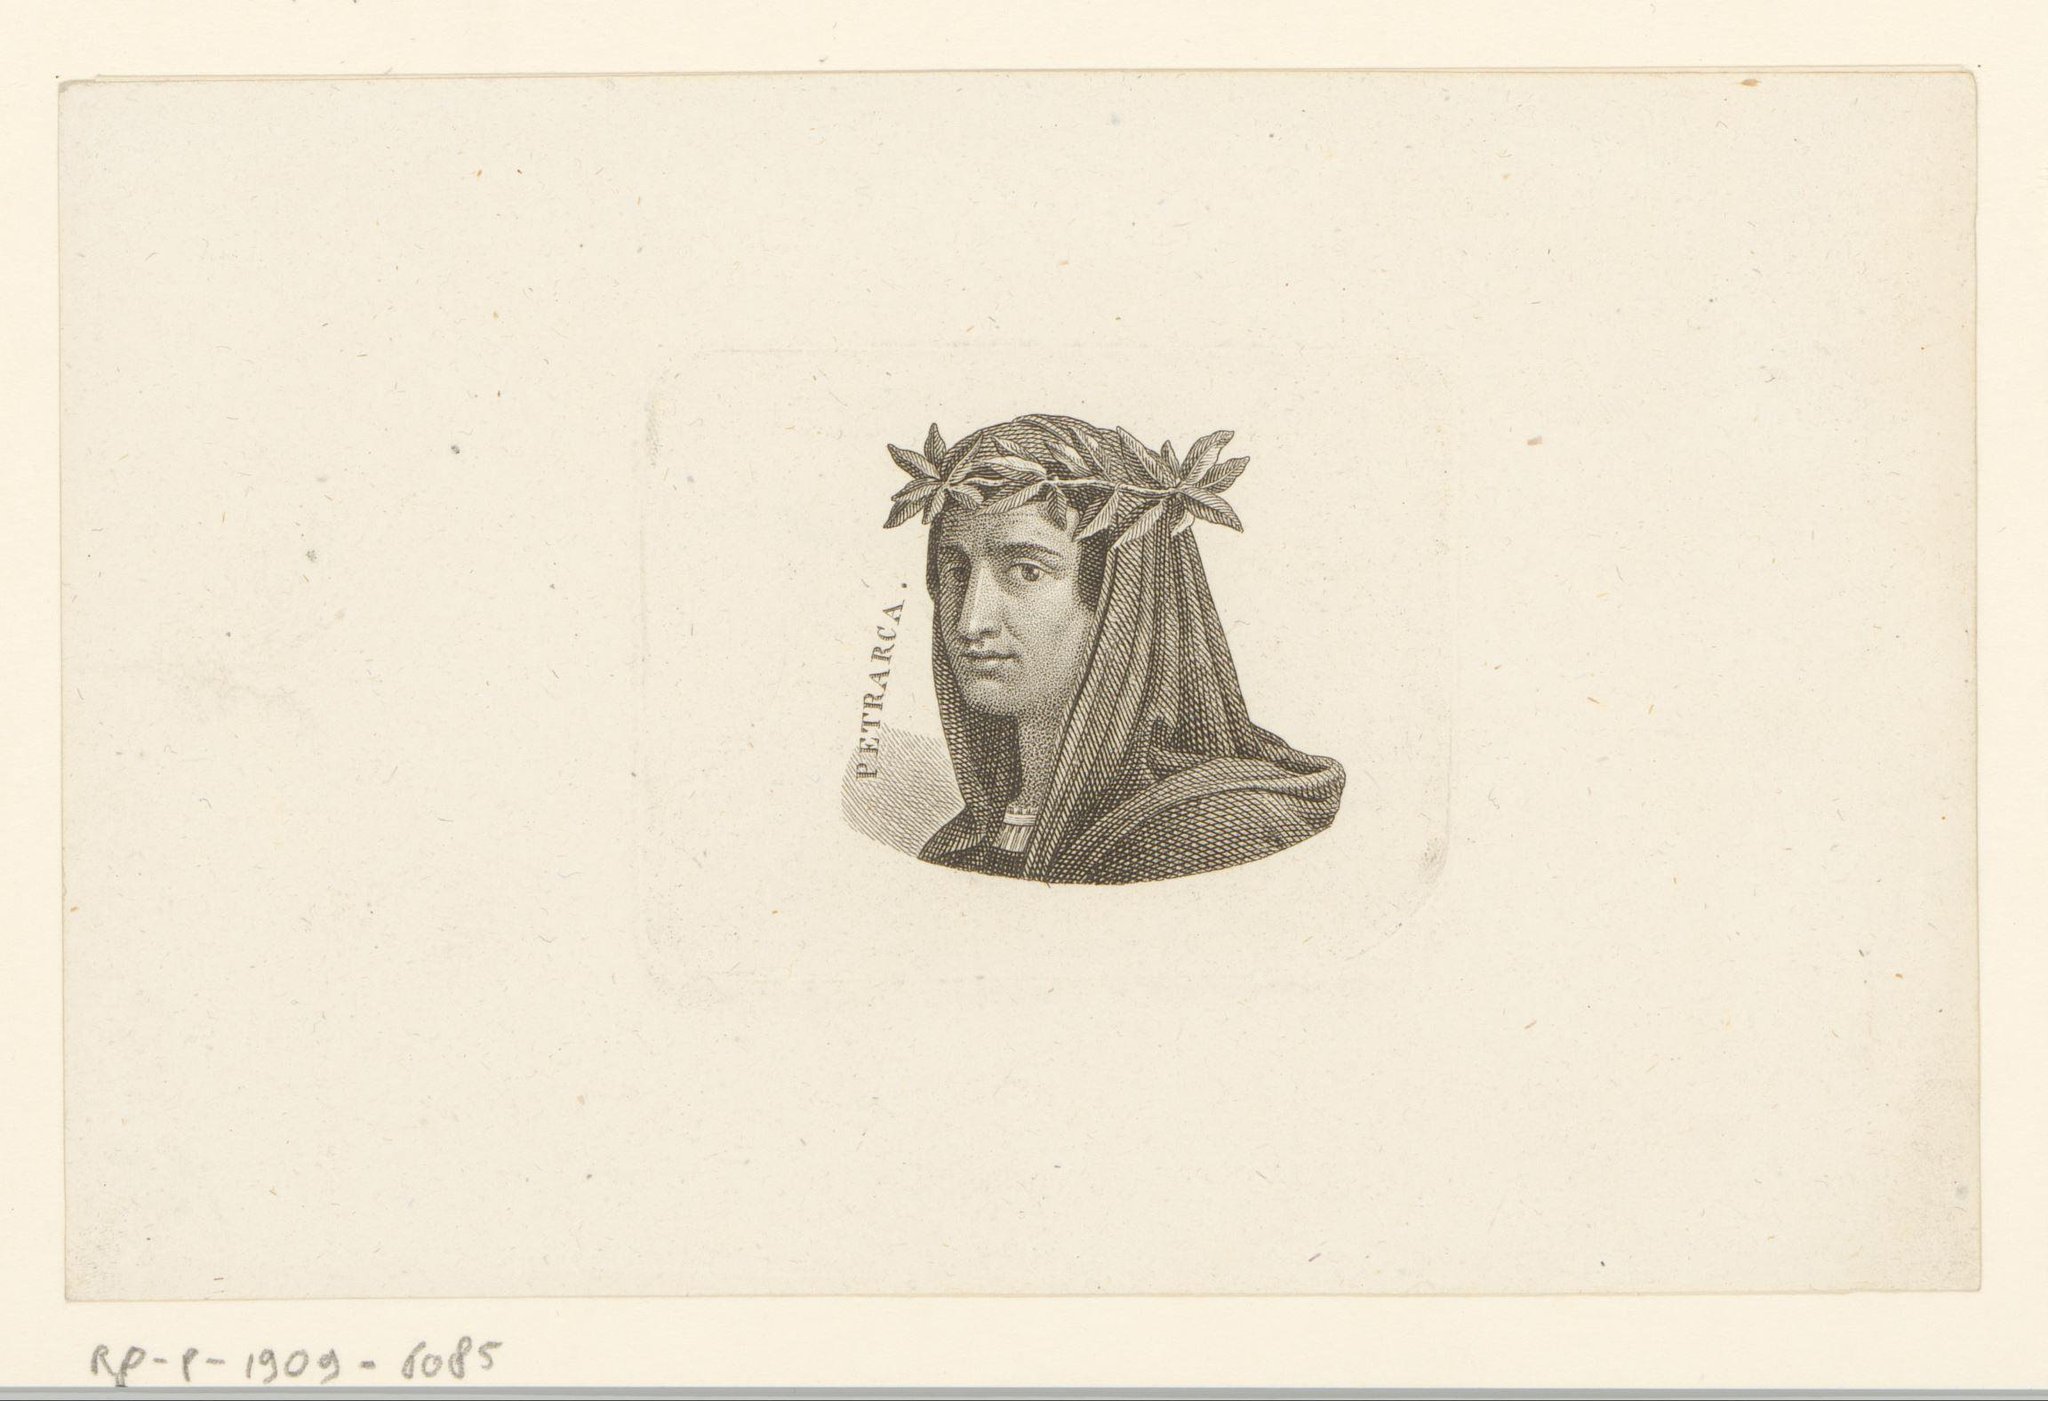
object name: print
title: Portret van Francesco Petrarca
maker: ernst ludwig riepenhausen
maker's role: print maker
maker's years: 1765-1840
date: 1775-1840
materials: paper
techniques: engraving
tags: francesco petrarca, honouring the artist with laurel wreath, historical persons, portrait of a writer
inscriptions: collector's mark: Lugt 2228